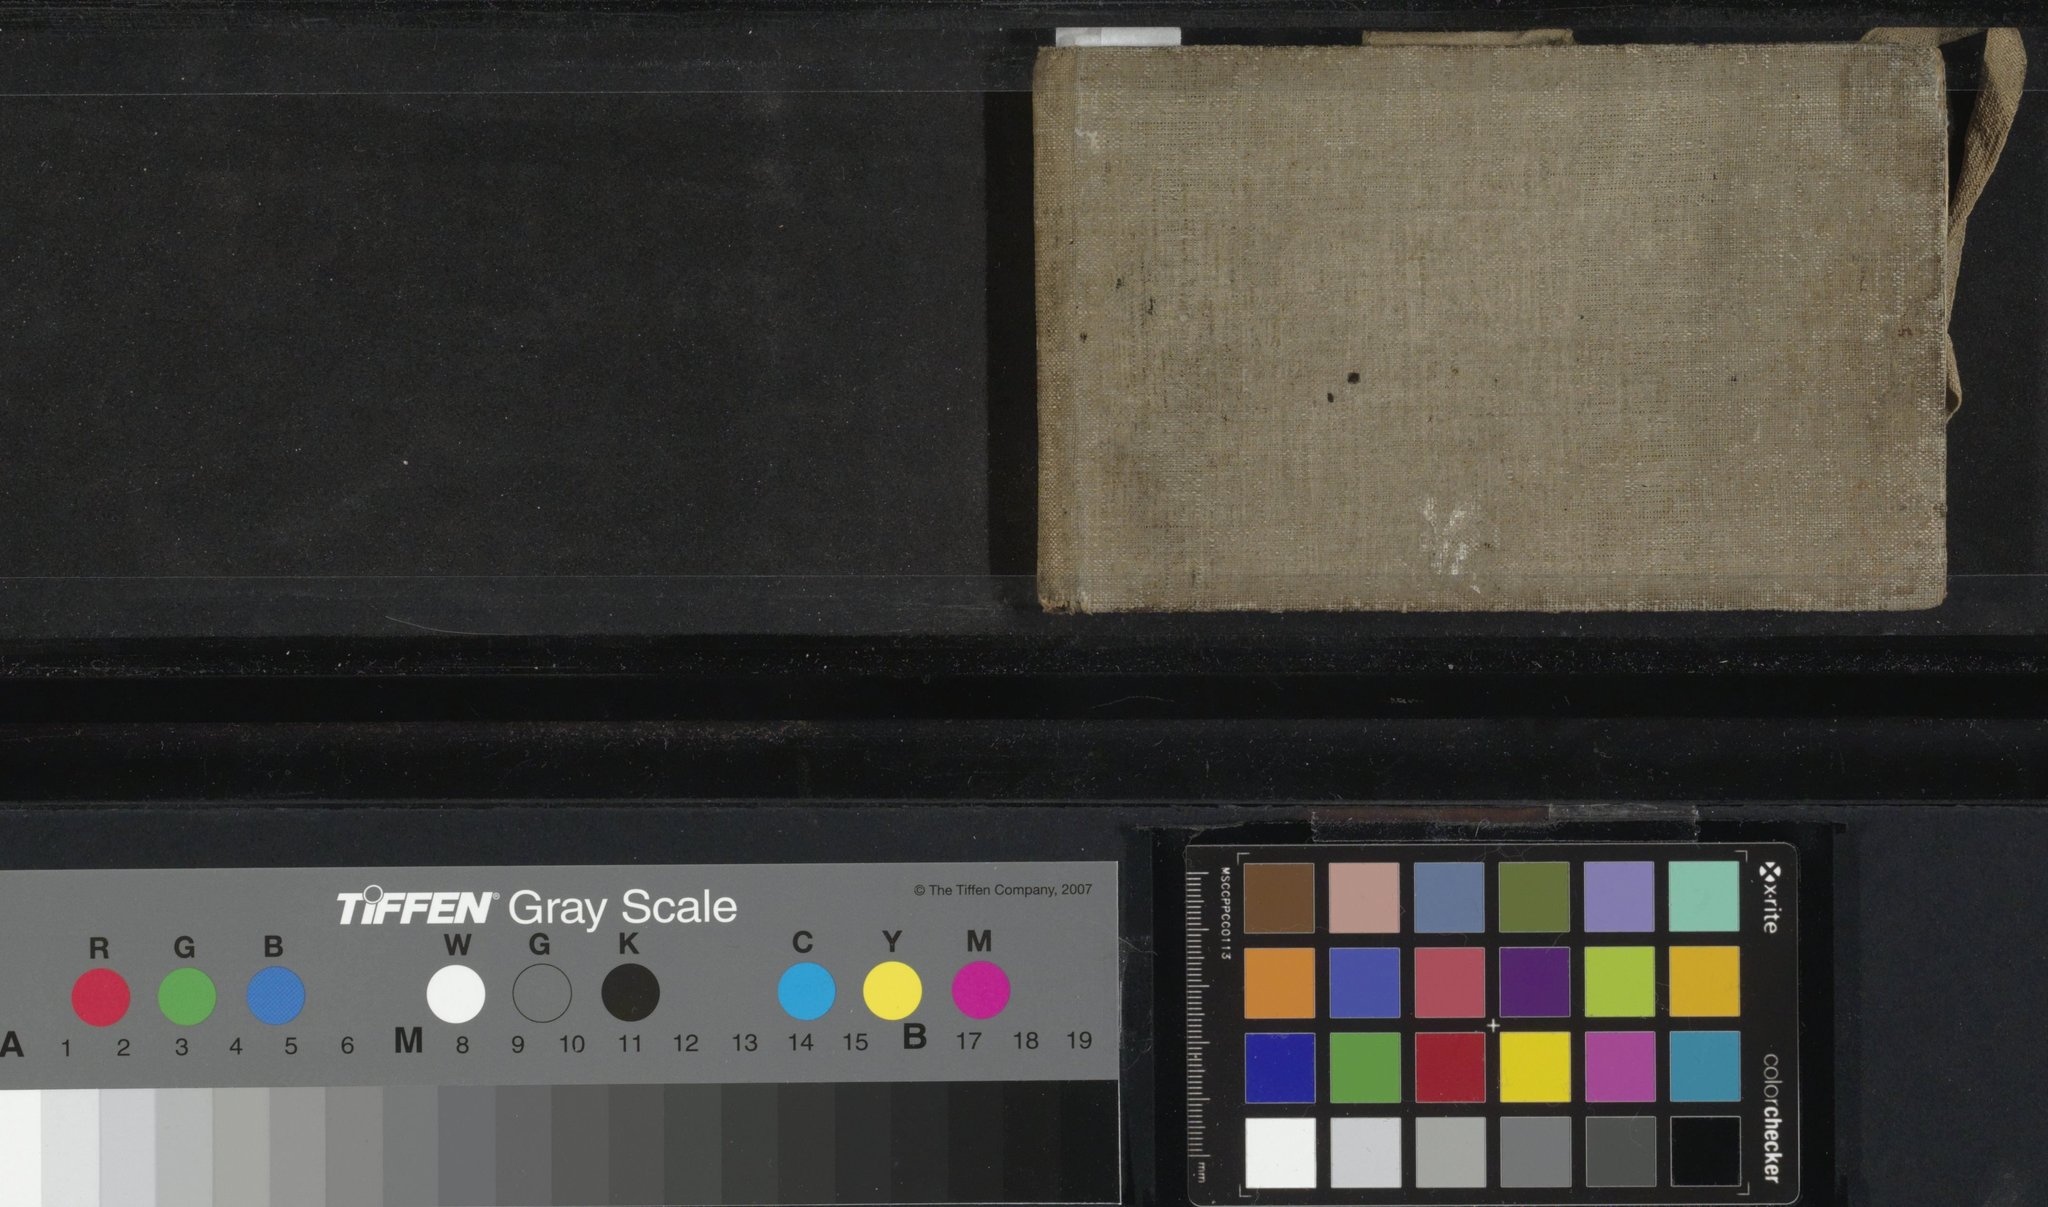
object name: sketchbook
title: Schetsboek met 46 bladen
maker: george clausen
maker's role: draughtsman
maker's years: 1852-1912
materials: chalk, paper, pencil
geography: noordhollandsch kanaal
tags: city-view, and landscape with man-made constructions, landscapes with waters, waterscapes, seascapes (in the temperate zone), folk costume, regional costume, amsterdam, hoorn (north holland)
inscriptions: collector's mark: Lugt 2228a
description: Schetsboek bestaande uit 46 bladen met schetsen gemaakt tijdens een reis door Noord-Holland. Voornamelijk figuren in klederdracht, stads-en dorpsgezichten, havens en kanalen. Tevens een kopie naar Rembrandts 'De Staalmeesters'.